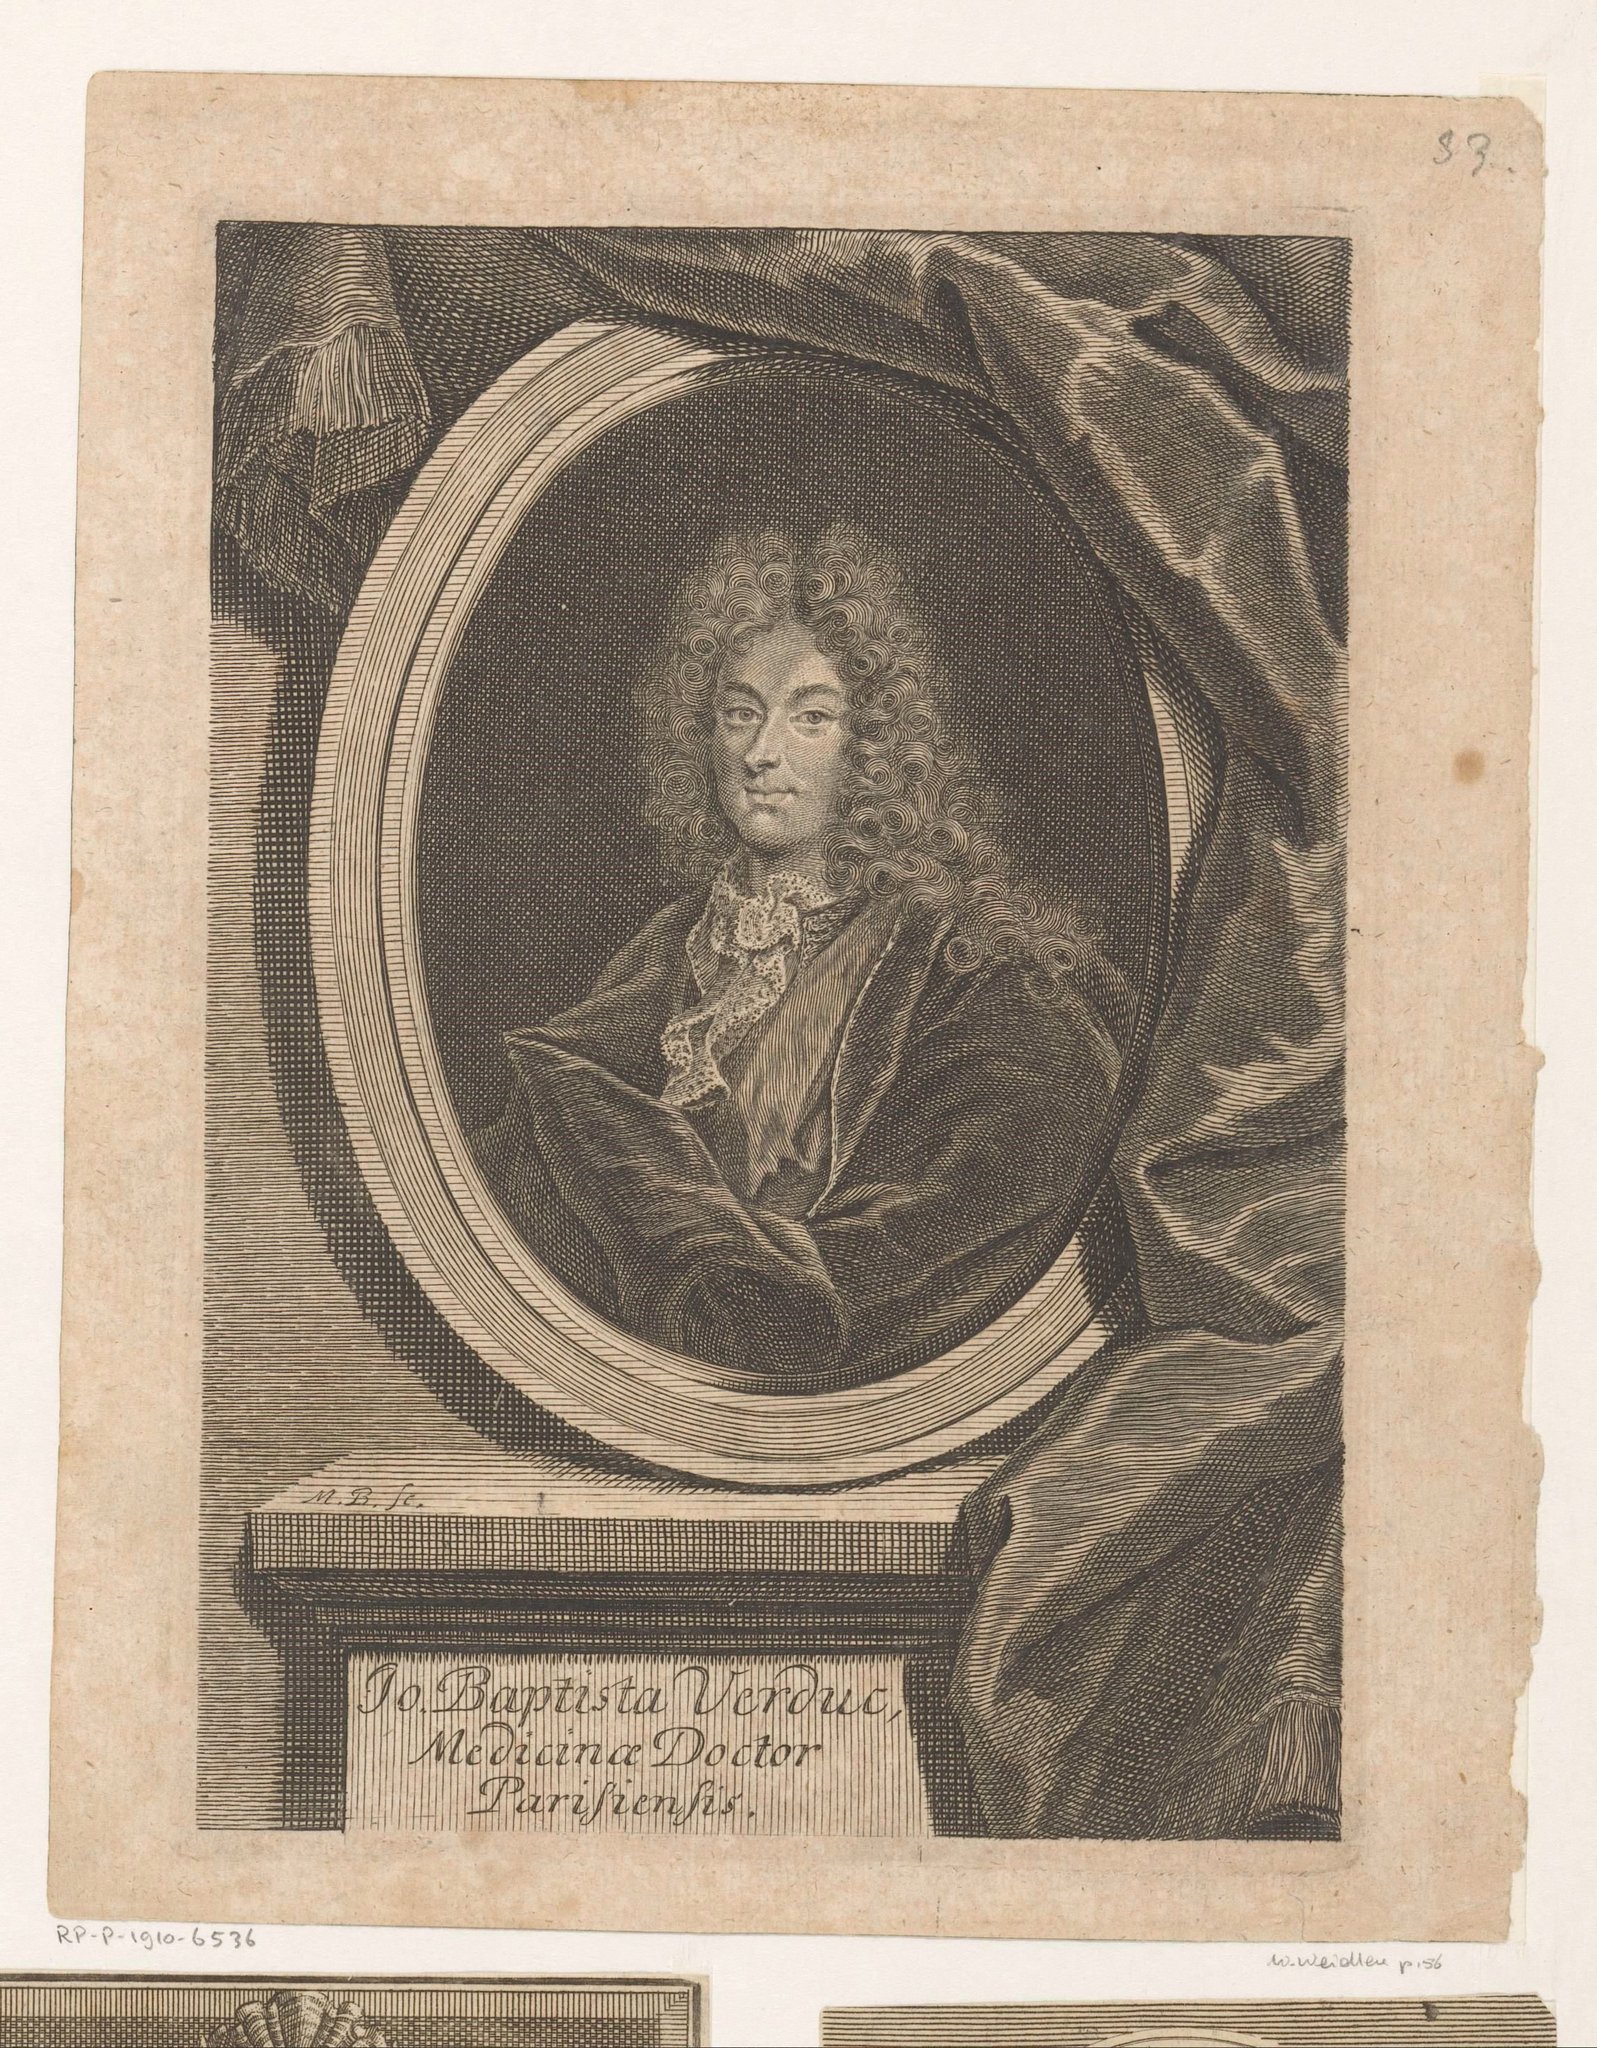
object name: print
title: Portret van Jean-Baptiste Verduc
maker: martin bernigeroth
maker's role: print maker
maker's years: 1670-1733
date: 1694-1733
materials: paper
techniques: engraving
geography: leipzig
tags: historical persons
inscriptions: collector's mark: Lugt 2228